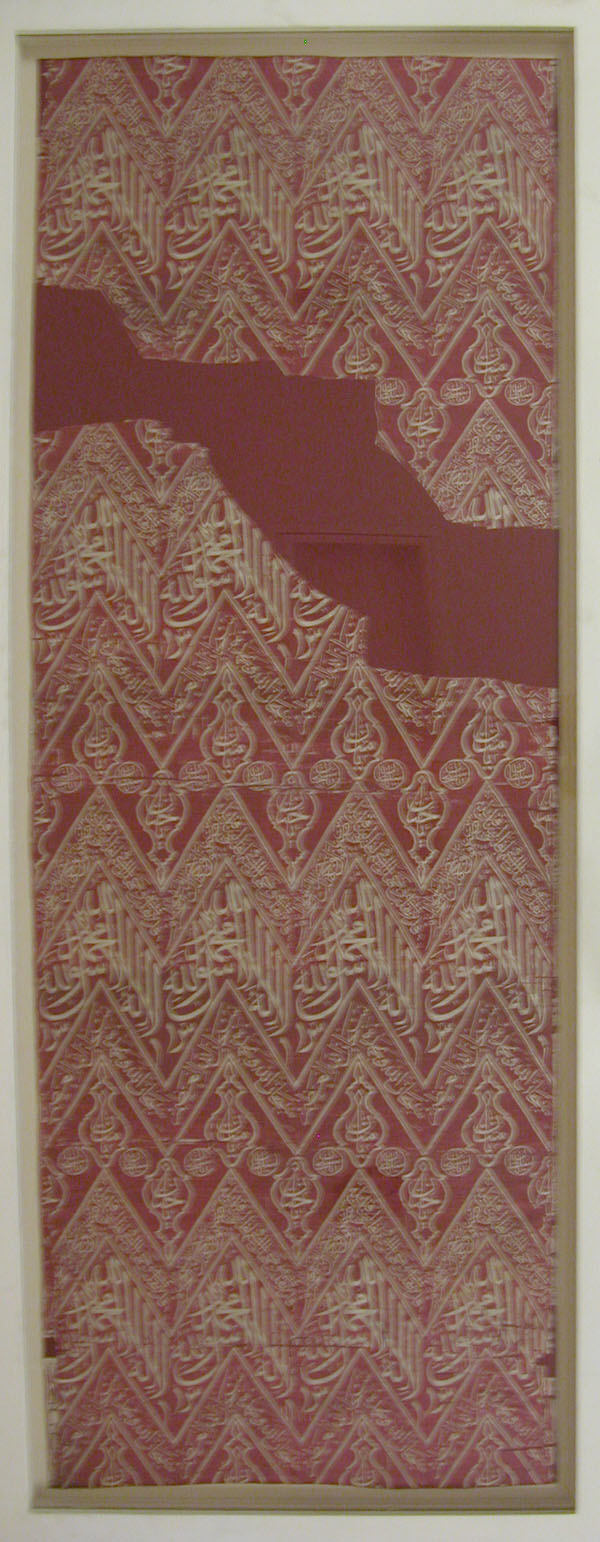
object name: tomb cover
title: Fragmentary Cenotaph Cover with Calligraphic Inscriptions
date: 1601-1800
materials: silk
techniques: lampas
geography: turkey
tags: arabic